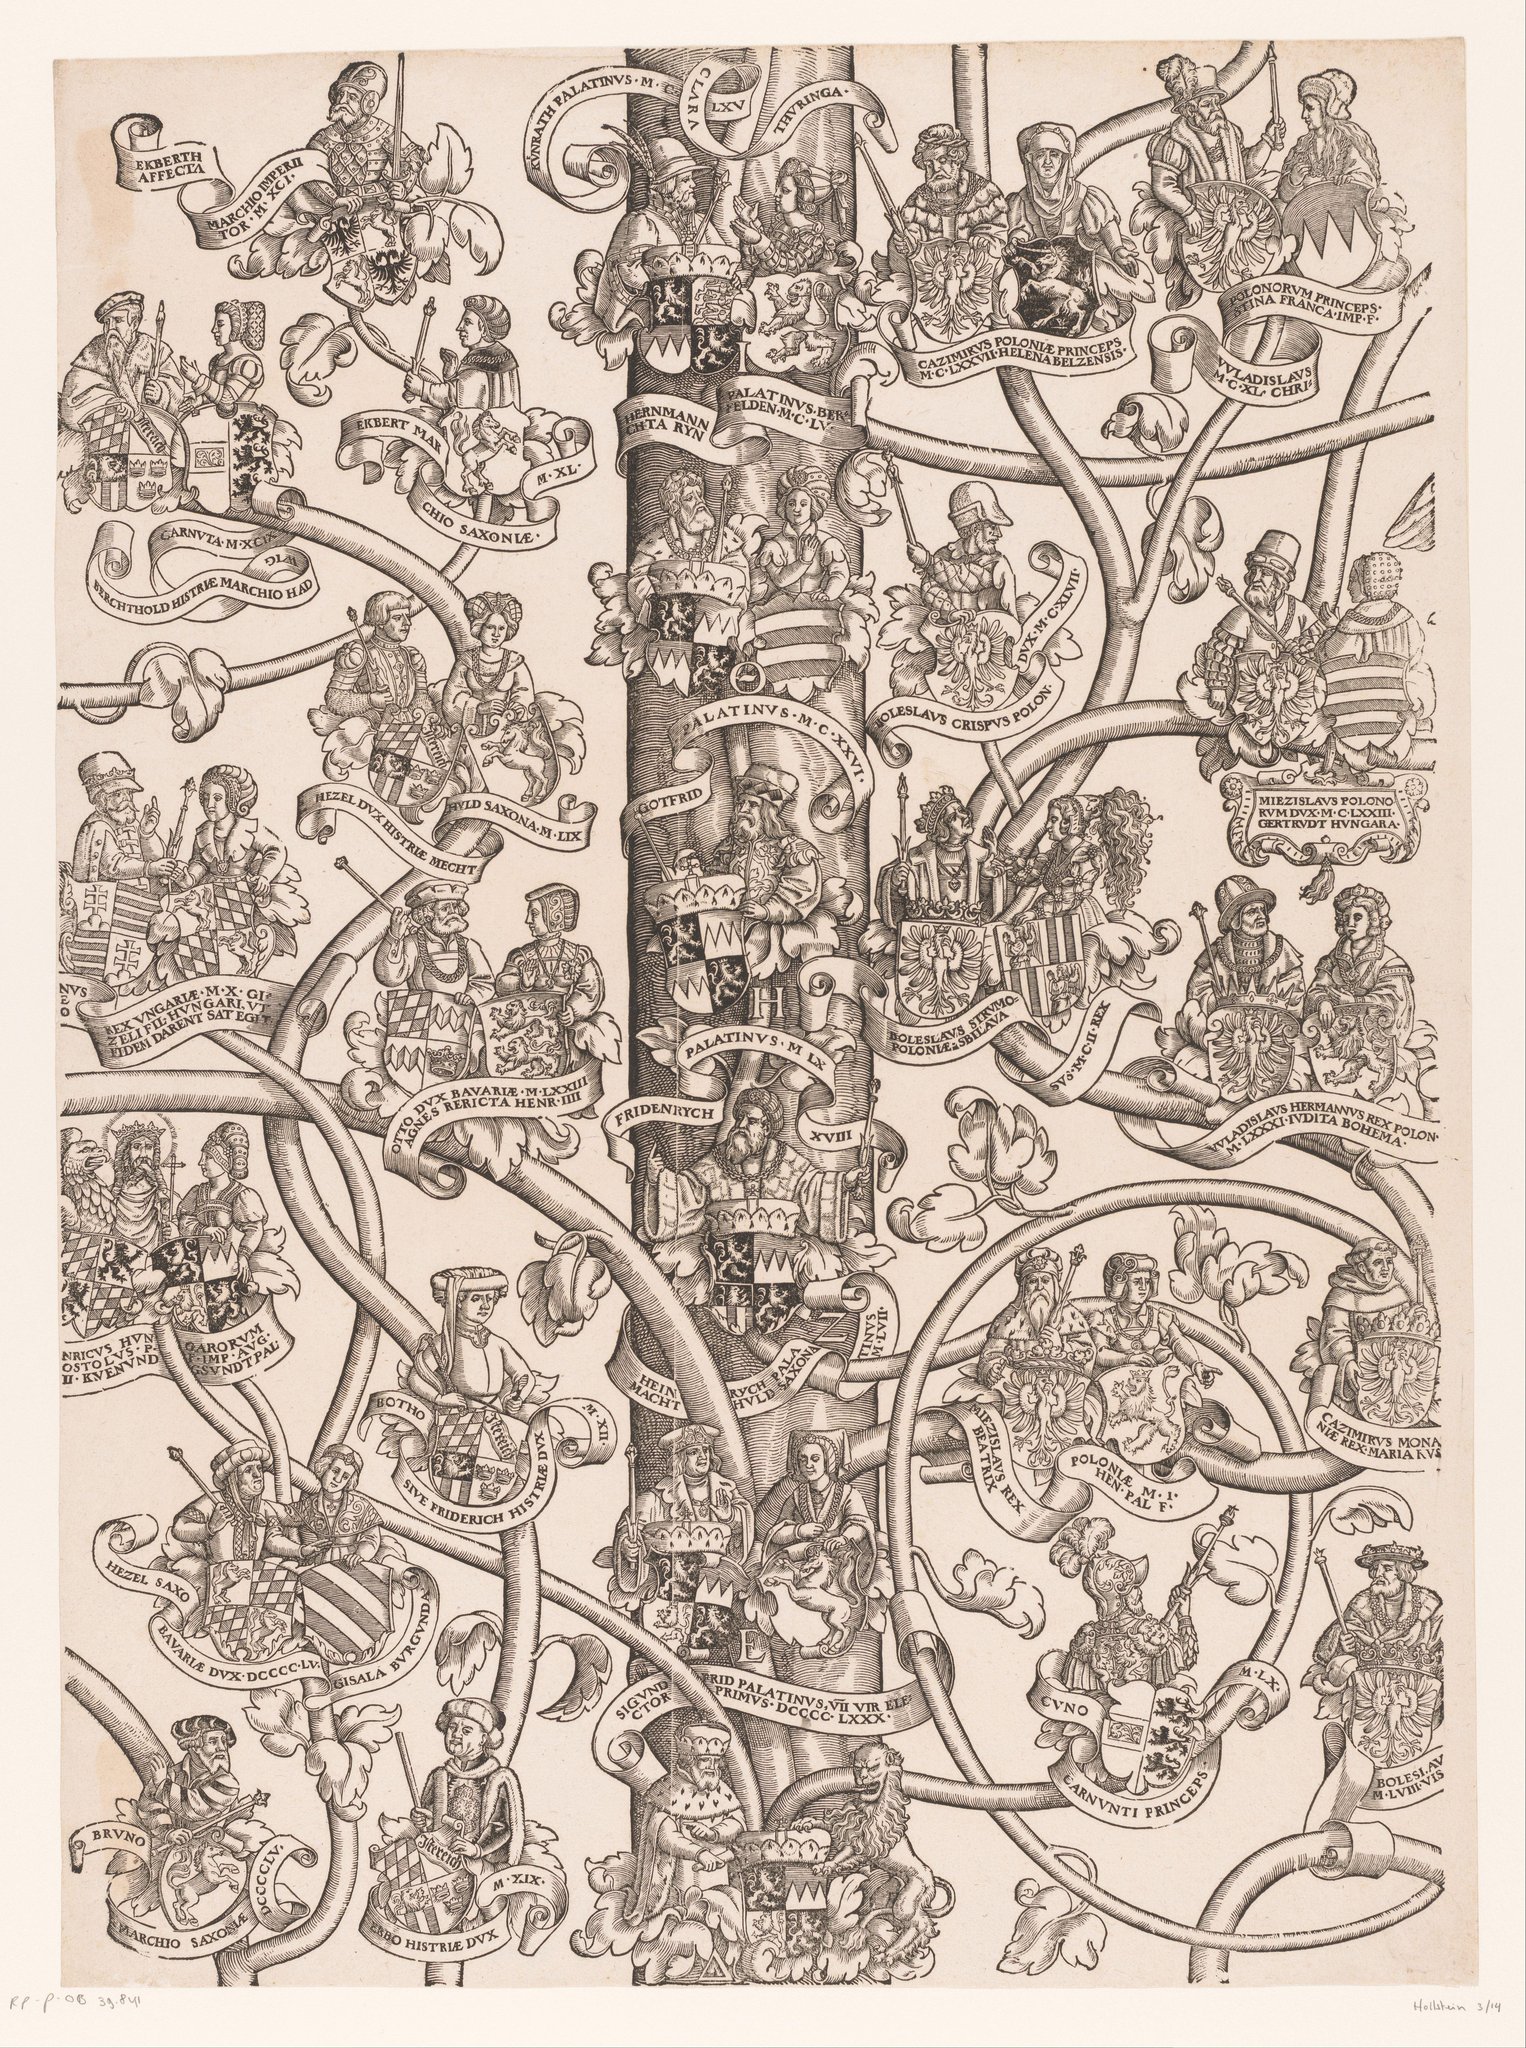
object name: print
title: Stamboom van Frederik en Ottheinrich van Palts-Neuburg (plaat 14)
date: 1535-1594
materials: paper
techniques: letterpress printing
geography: basel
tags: amberg, earl, family lineage, pedigree, genealogical tree or table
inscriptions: collector's mark: Lugt 240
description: Blad 14 van een stamboom bestaande uit 21 bladen, gedrukt van 42 blokken.